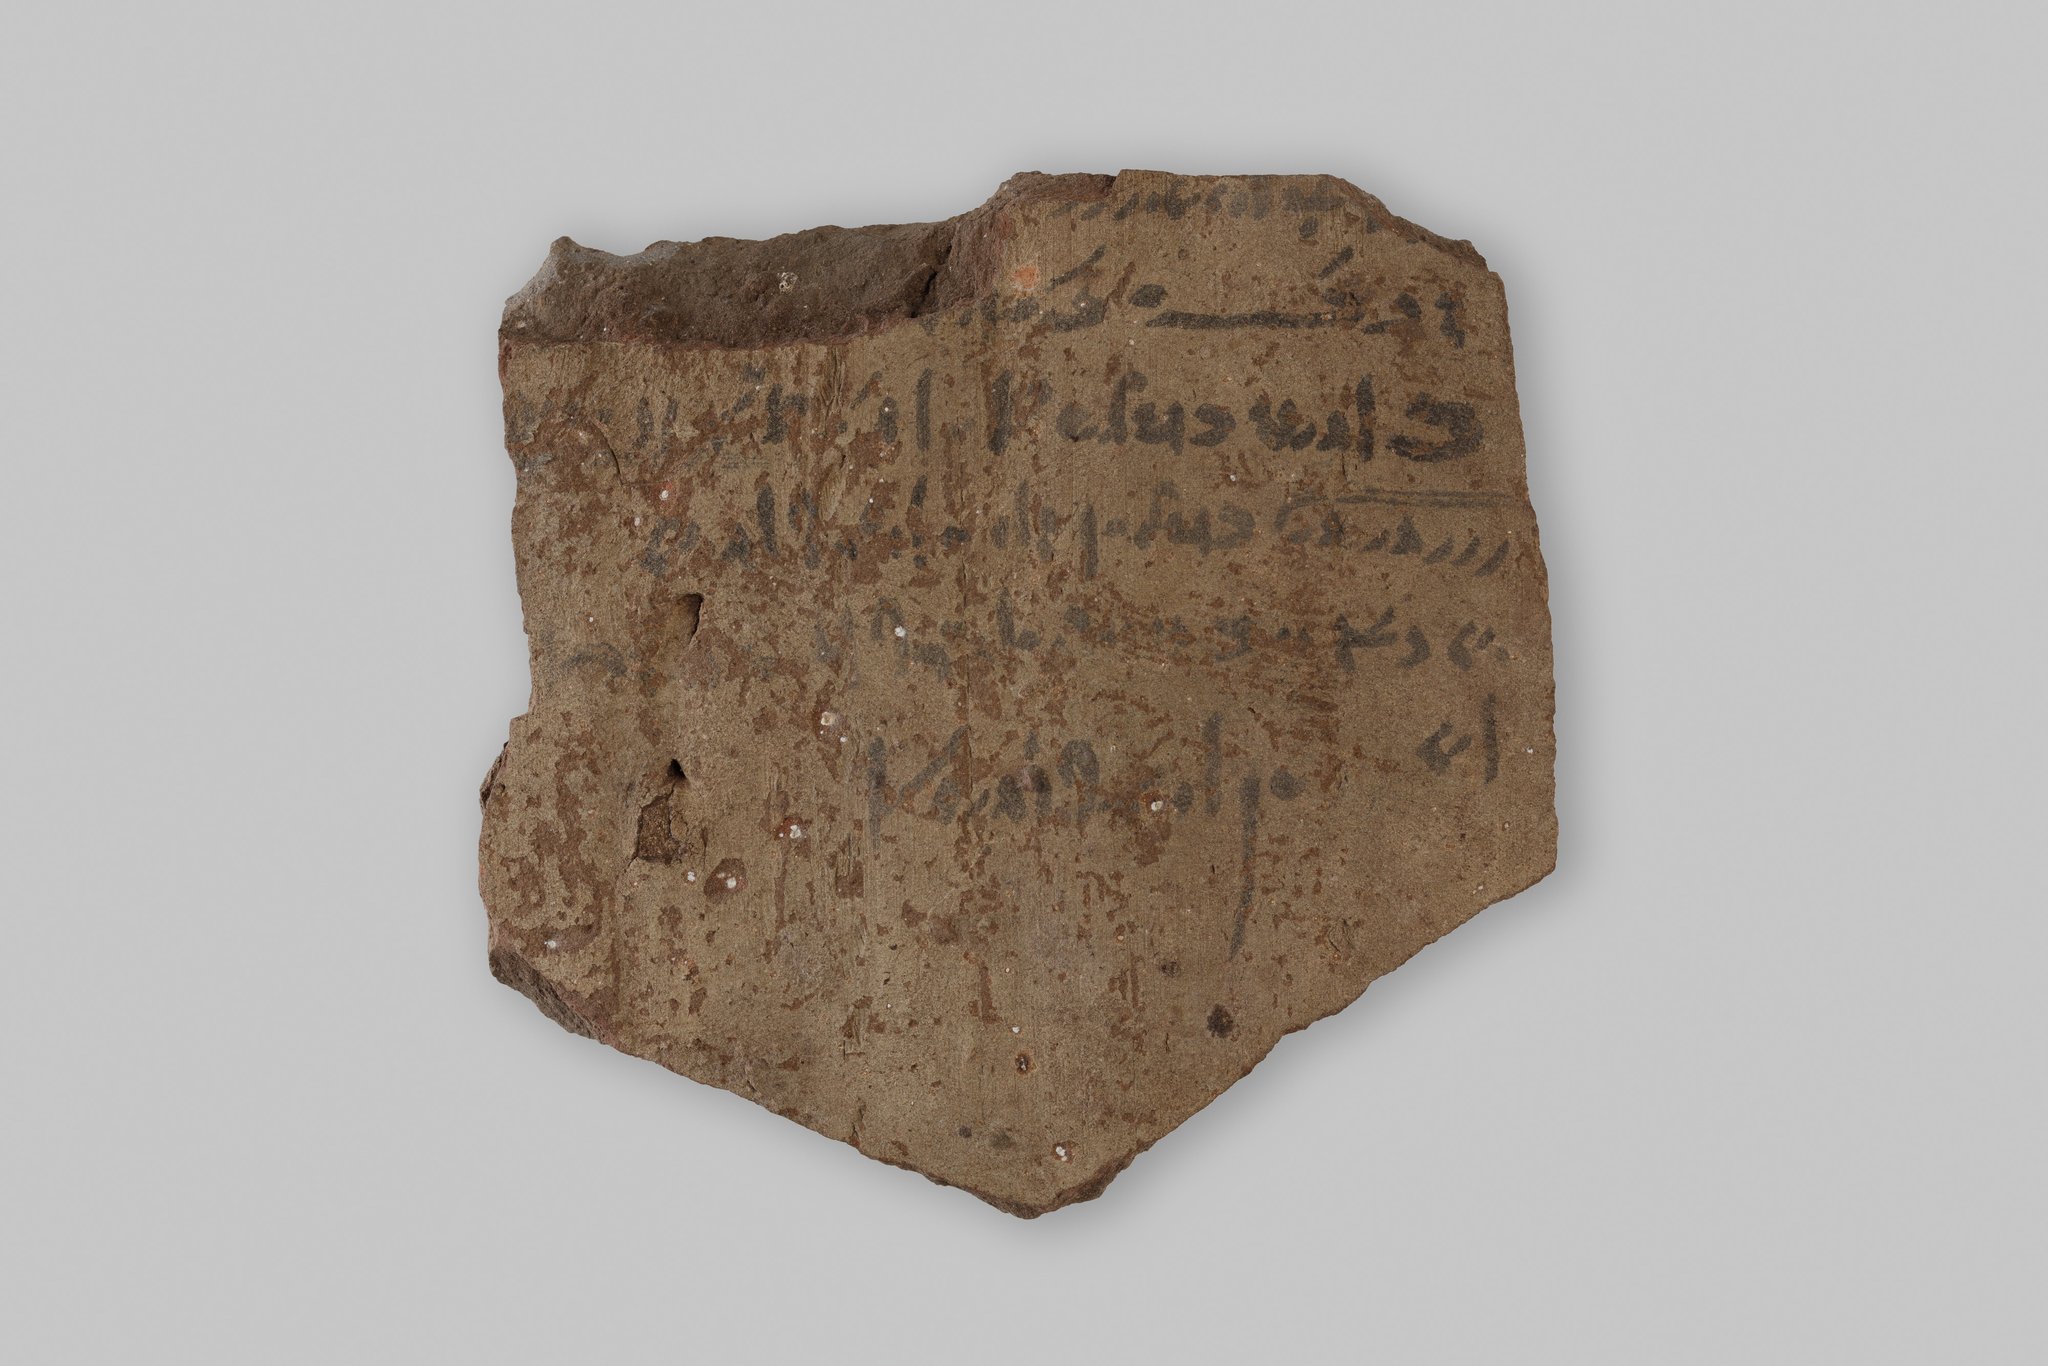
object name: ostracon, demotic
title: Ostracon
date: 600-30 BCE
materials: ink, pottery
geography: egypt